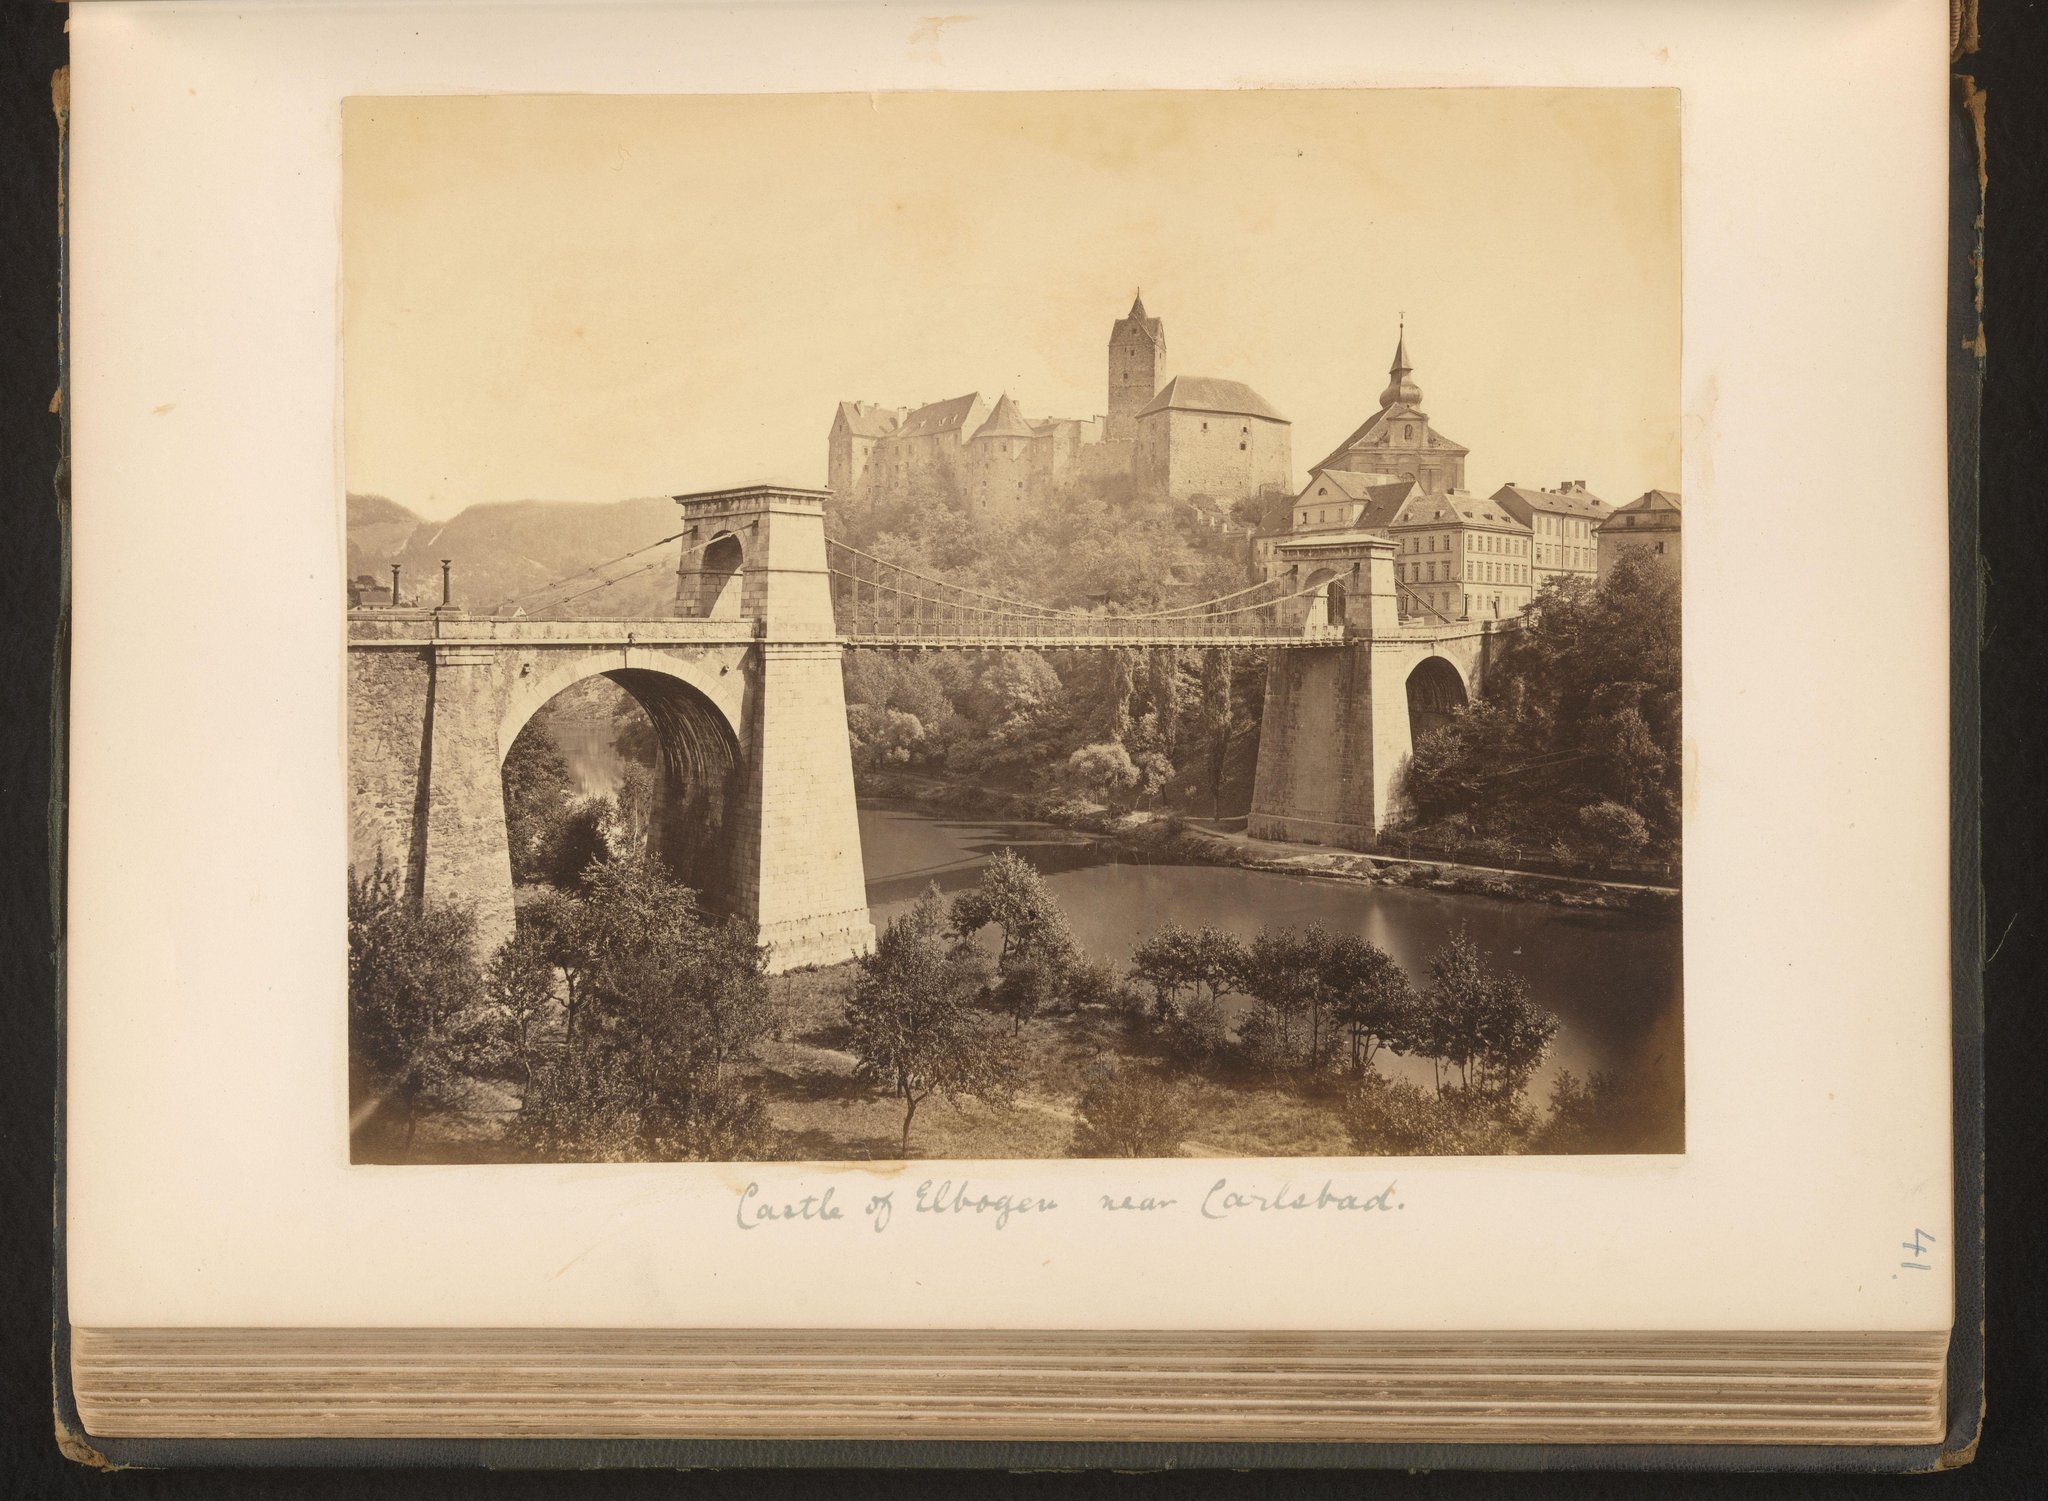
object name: album leaf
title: Gezicht op Kasteel Loket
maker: Anonymous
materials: paper, photographic support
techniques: albumen print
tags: castle, landscapes with waters, waterscapes, seascapes (in the temperate zone), bridge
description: Deze pagina maakt deel uit van een album.